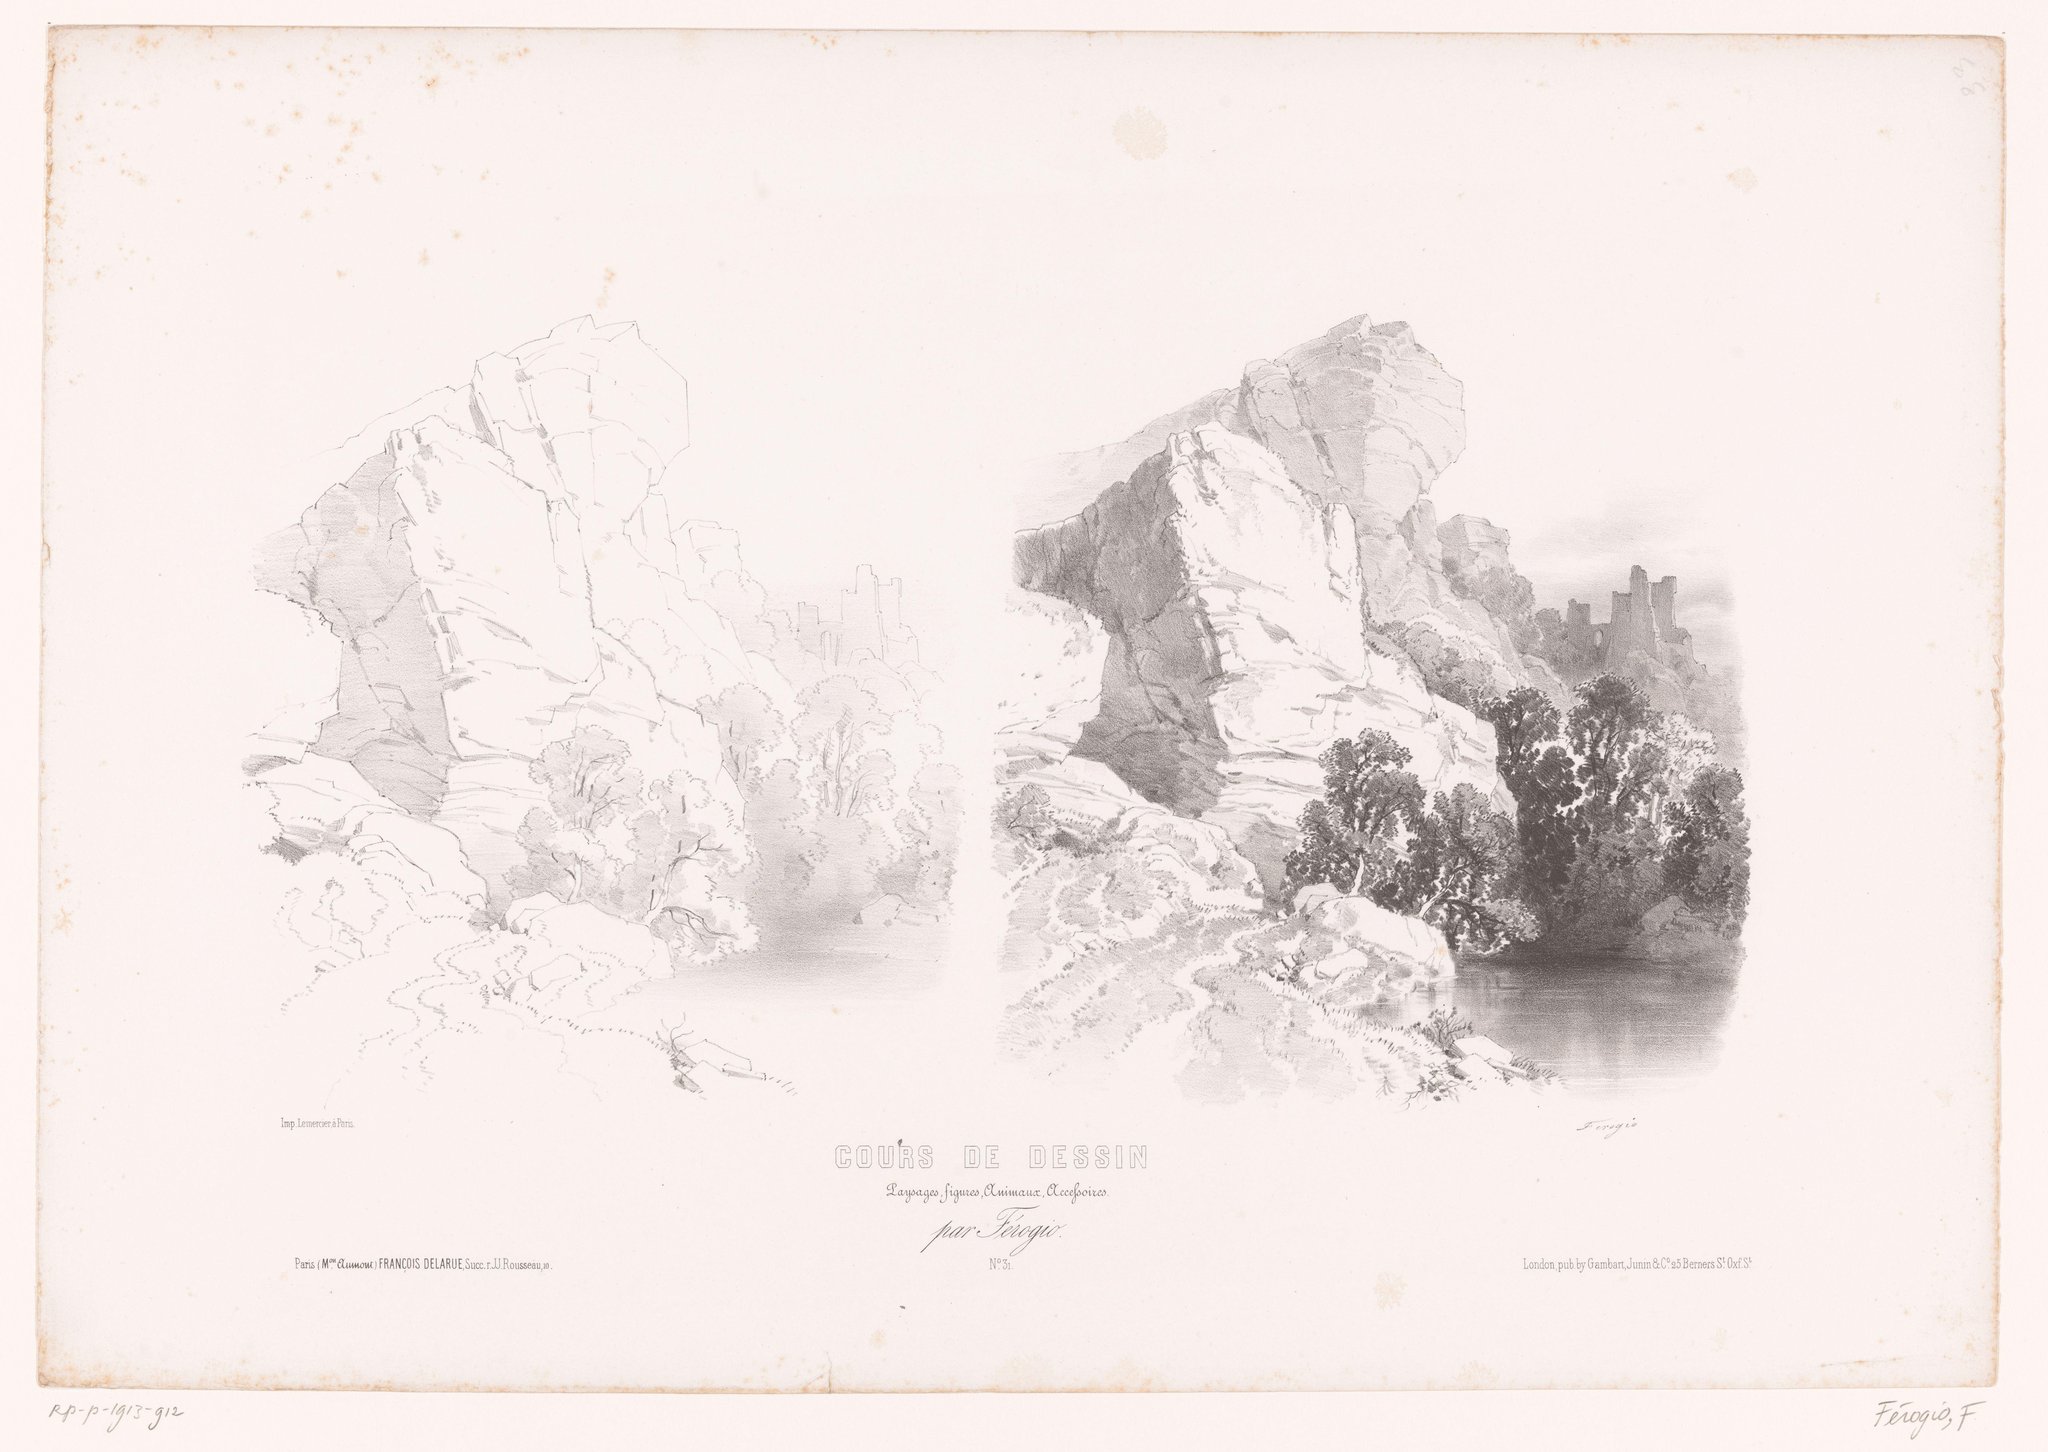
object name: print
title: Tekencursus met studies van landschappen, dieren en details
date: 1845-1846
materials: paper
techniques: lithograph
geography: london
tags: landscape with ruins, lake, rock-formations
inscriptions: collector's mark: Lugt 2228a